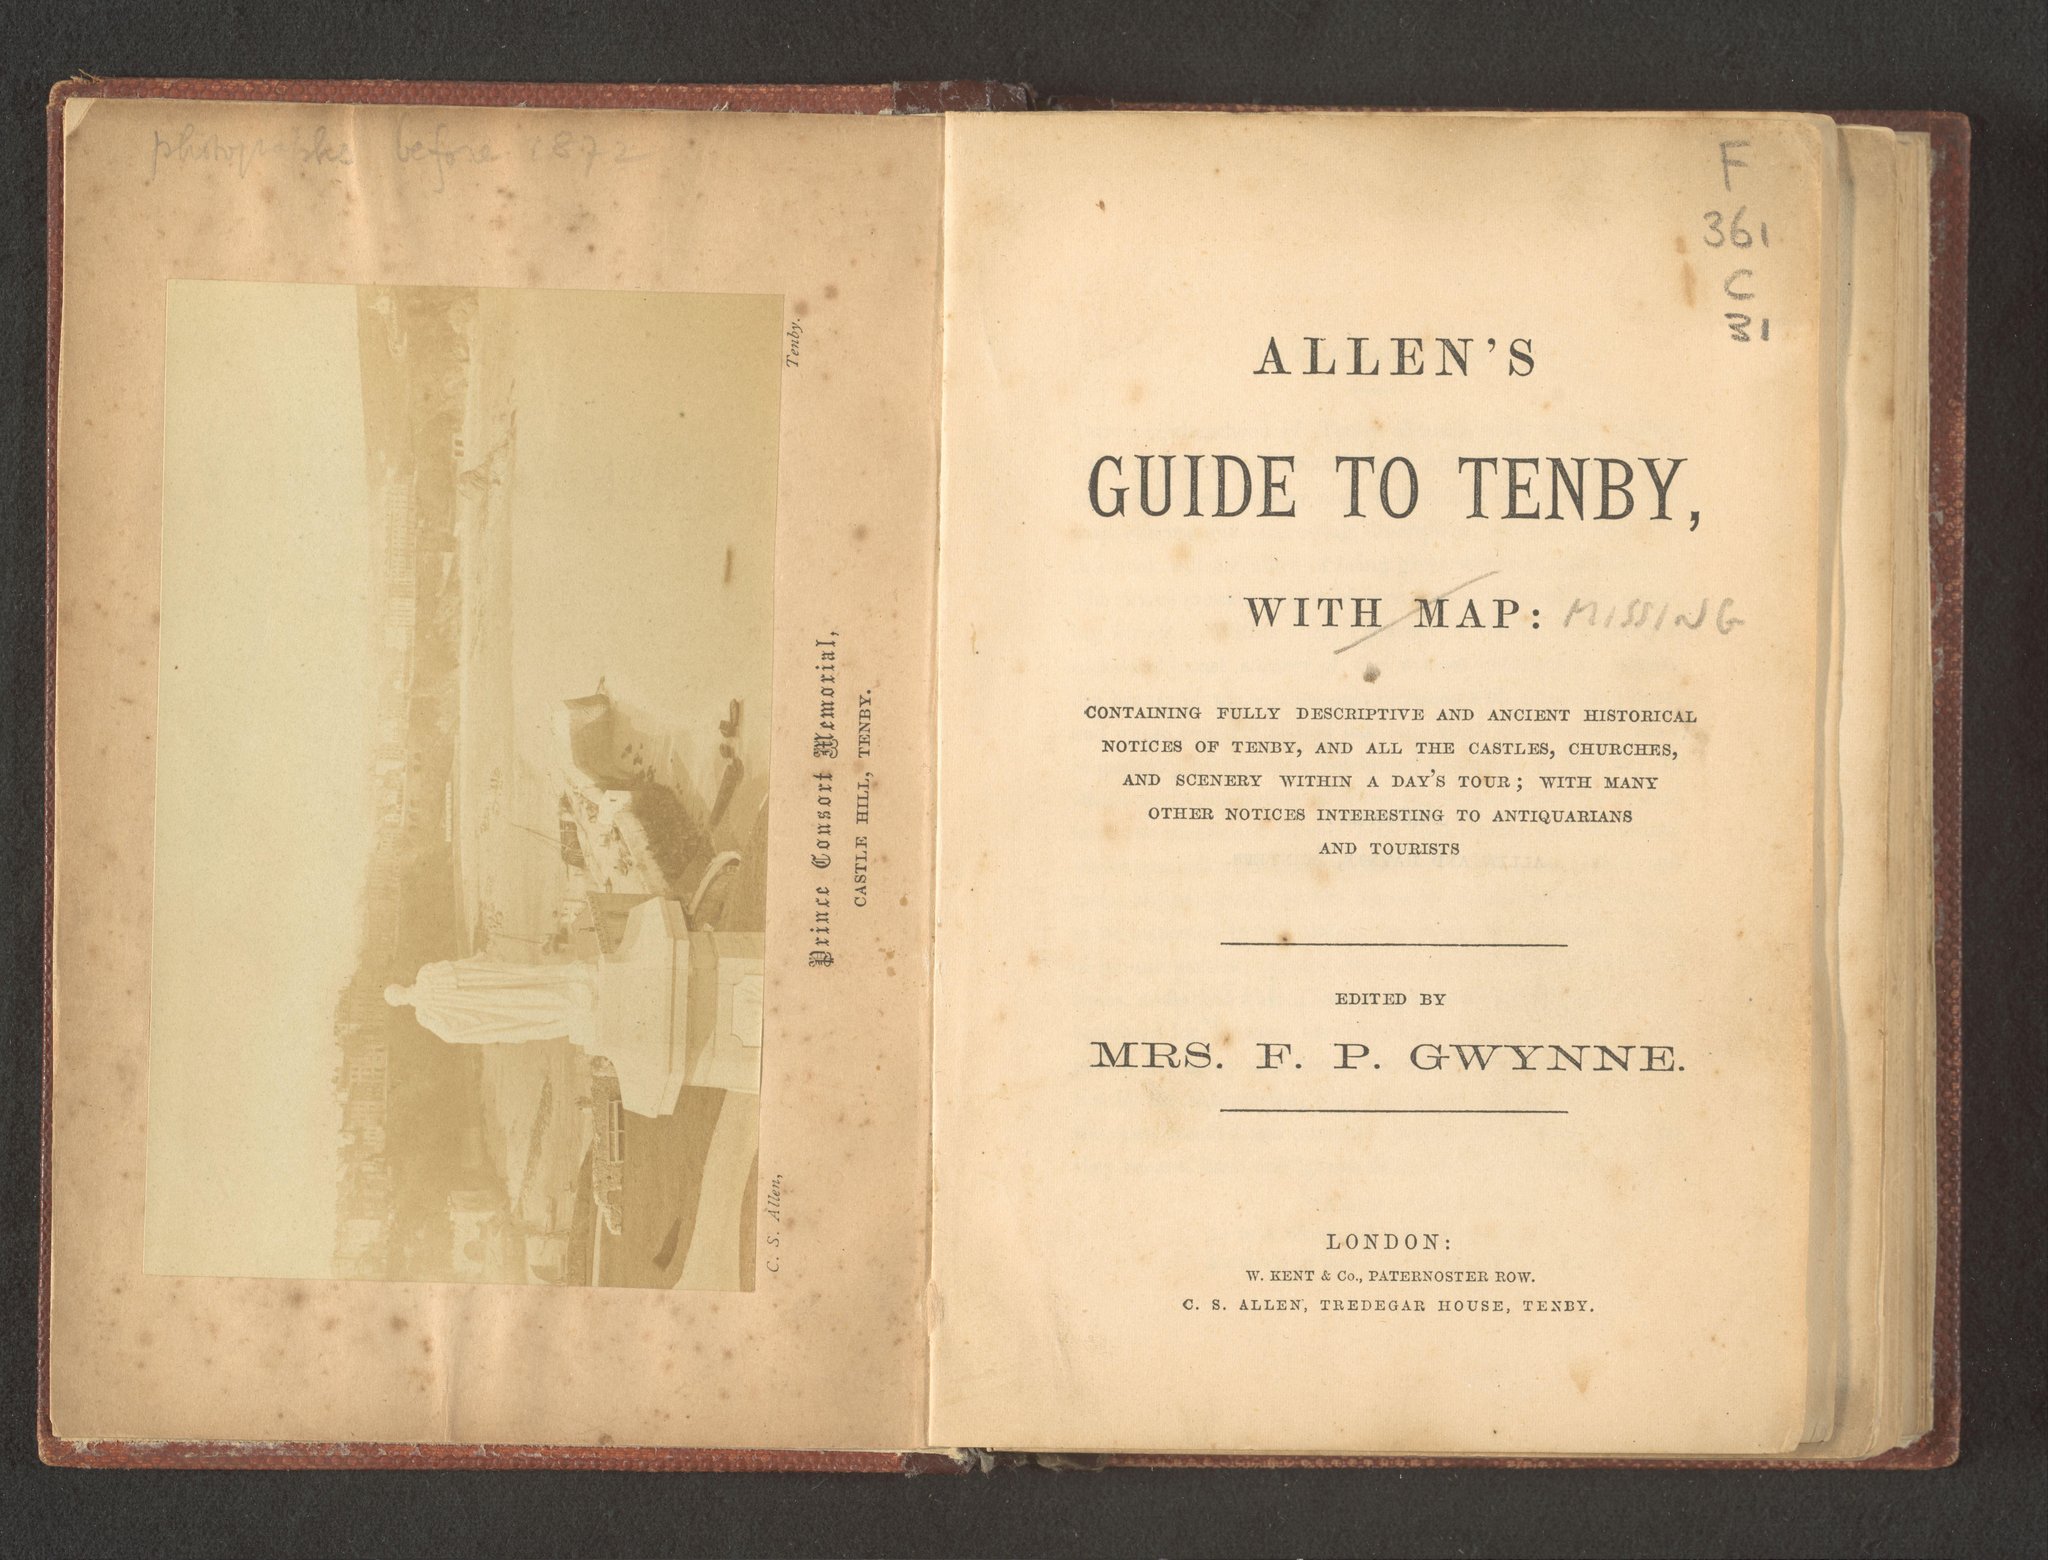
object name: book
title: Allen's guide to Tenby, with map : containing fully descriptive and ancient historical notices of Tenby, and all the castles, churches, and scenery within a day's tour; with many other notices interesting to antiquarians and tourists / ed. by mrs. F.P. Gwynne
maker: f.p. gwynne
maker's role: schrijver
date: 1870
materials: cardboard, leather, linen, paper, photographic support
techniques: albumen print, printing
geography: london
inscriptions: annotation: ‘4507/ D[.]B’, date: ‘AUG/ 2003’, annotation: ‘MAP MISSING/ c 1870’